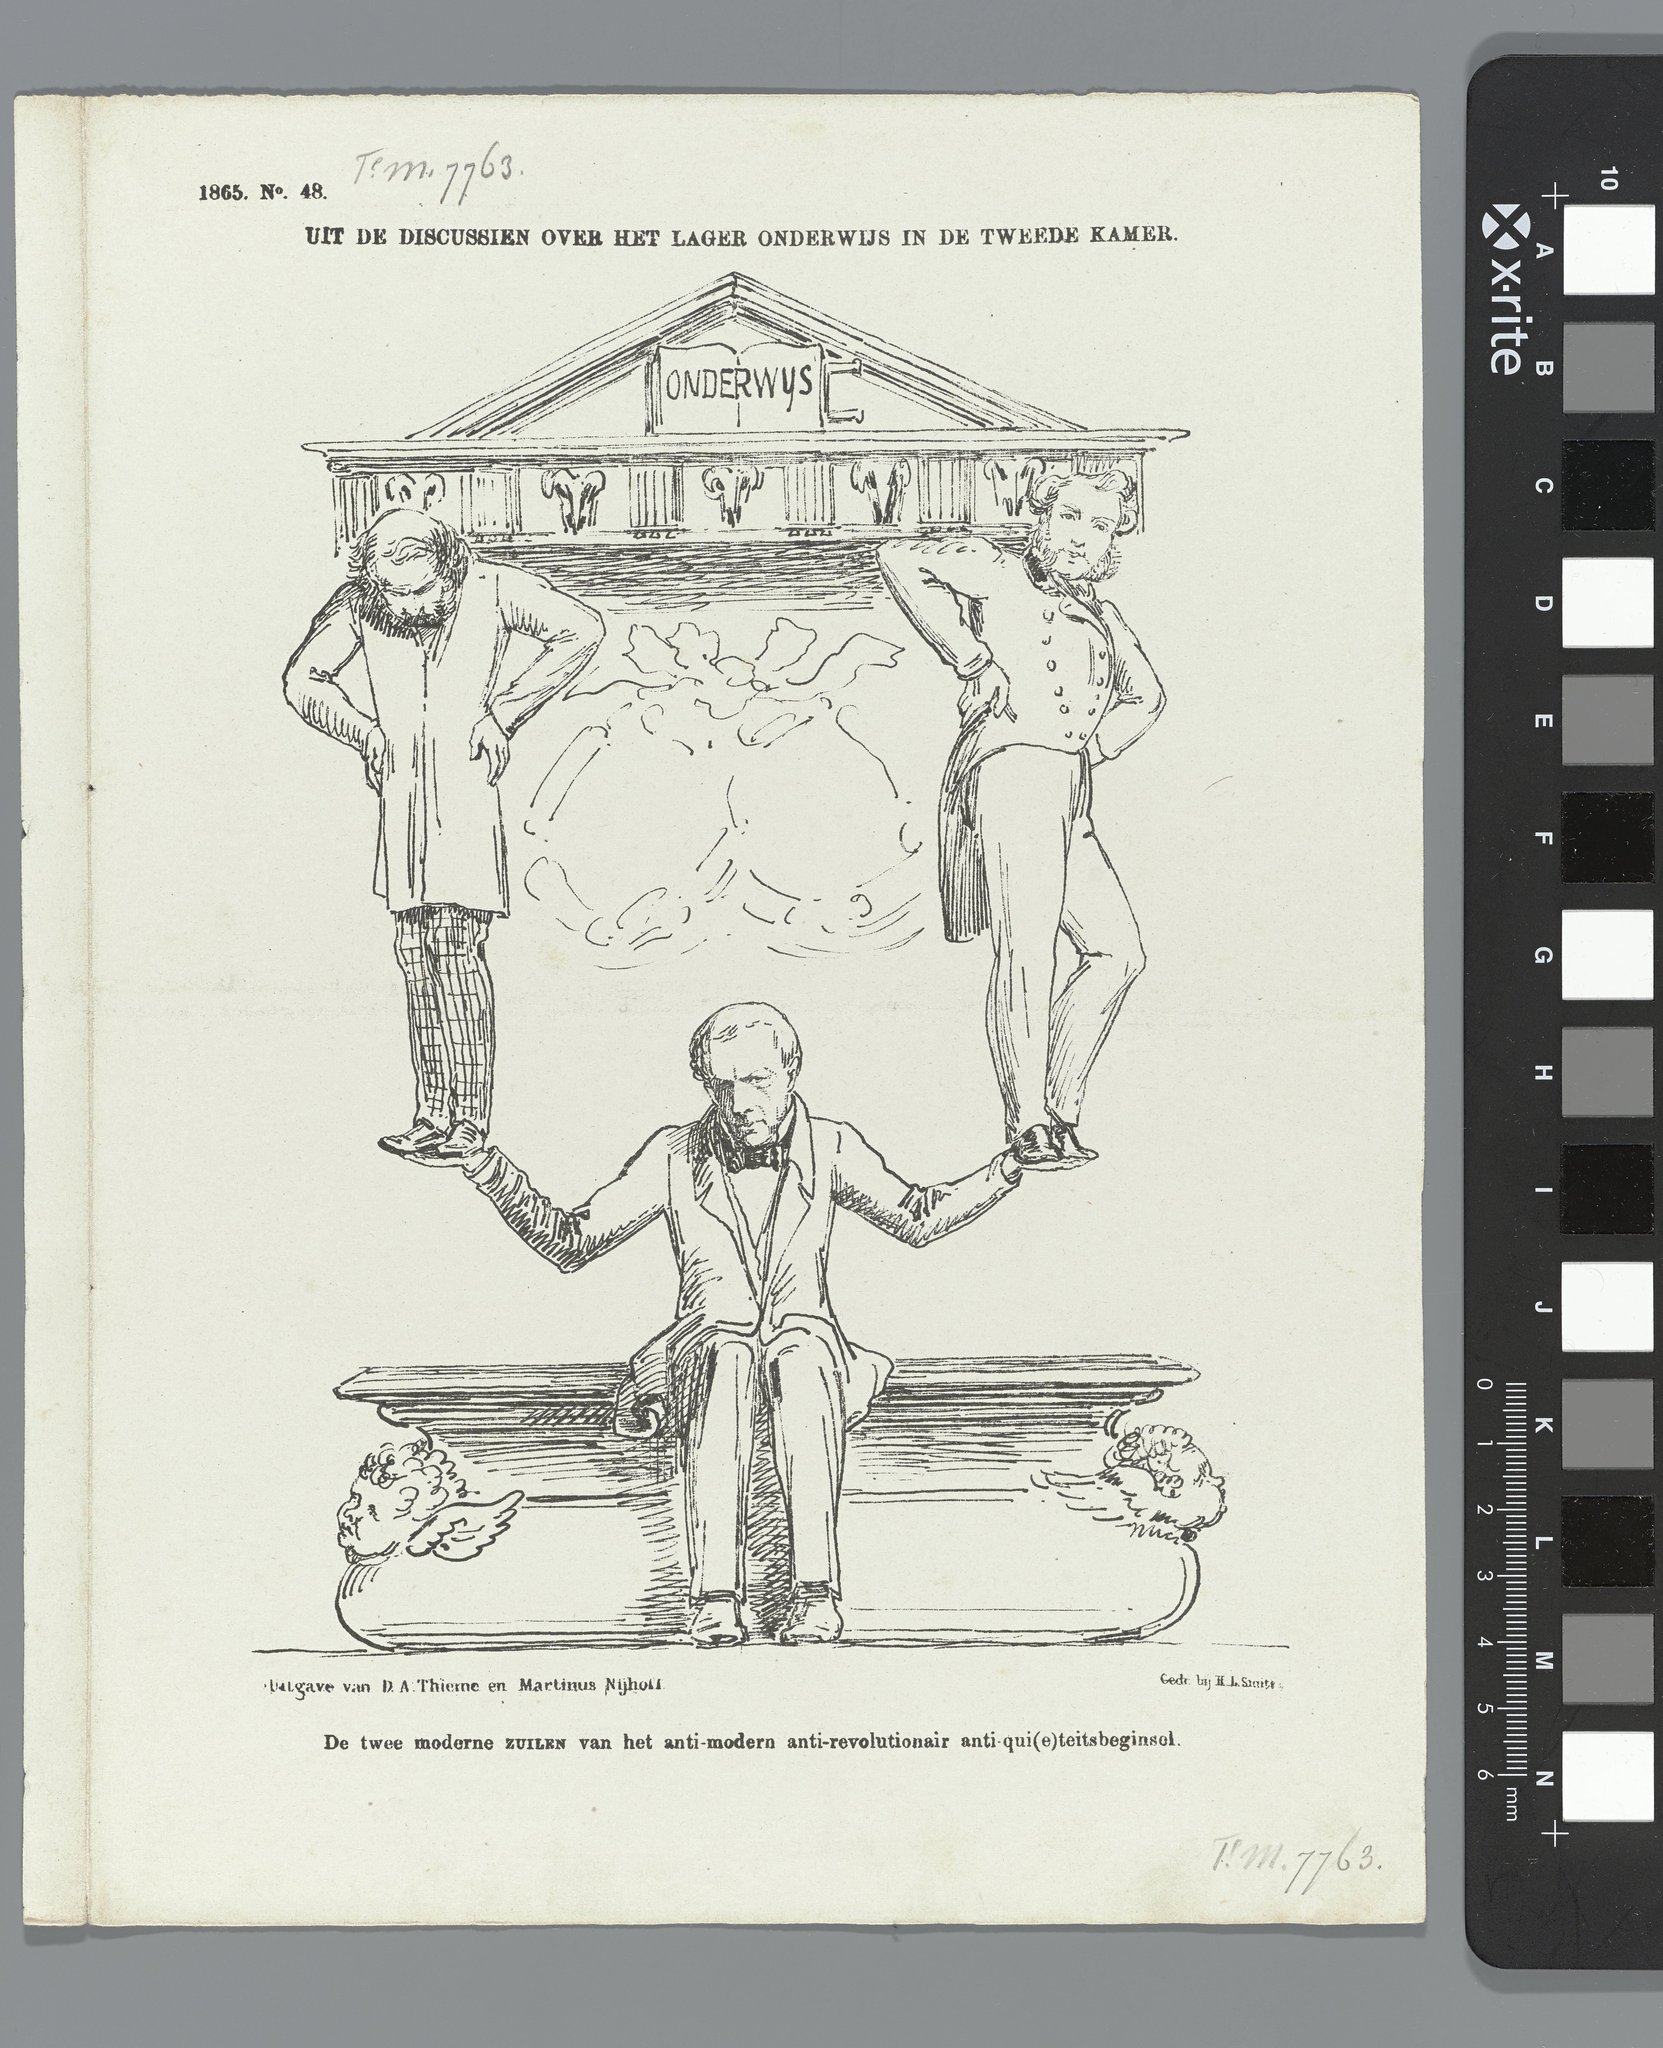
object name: print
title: Uit de discussien over het lager onderwijs in de Tweede Kamer / De twee moderne zuilen van het anti-modern ant-revolutionair anti-qui(e)teitsbeginsel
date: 1865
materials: paper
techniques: lithograph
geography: netherlands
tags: guillaume groen van prinsterer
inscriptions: collector's mark: Lugt 2228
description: Spotprent over de discussie over het lager onderwijs in de Tweede Kamer. Groen van Prinsterer draagt als Atlas het gehele onderwijsstelsel. Plaat verschenen bij het weekblad De Nederlandsche Spectator, nr. 48, 2 december 1865.